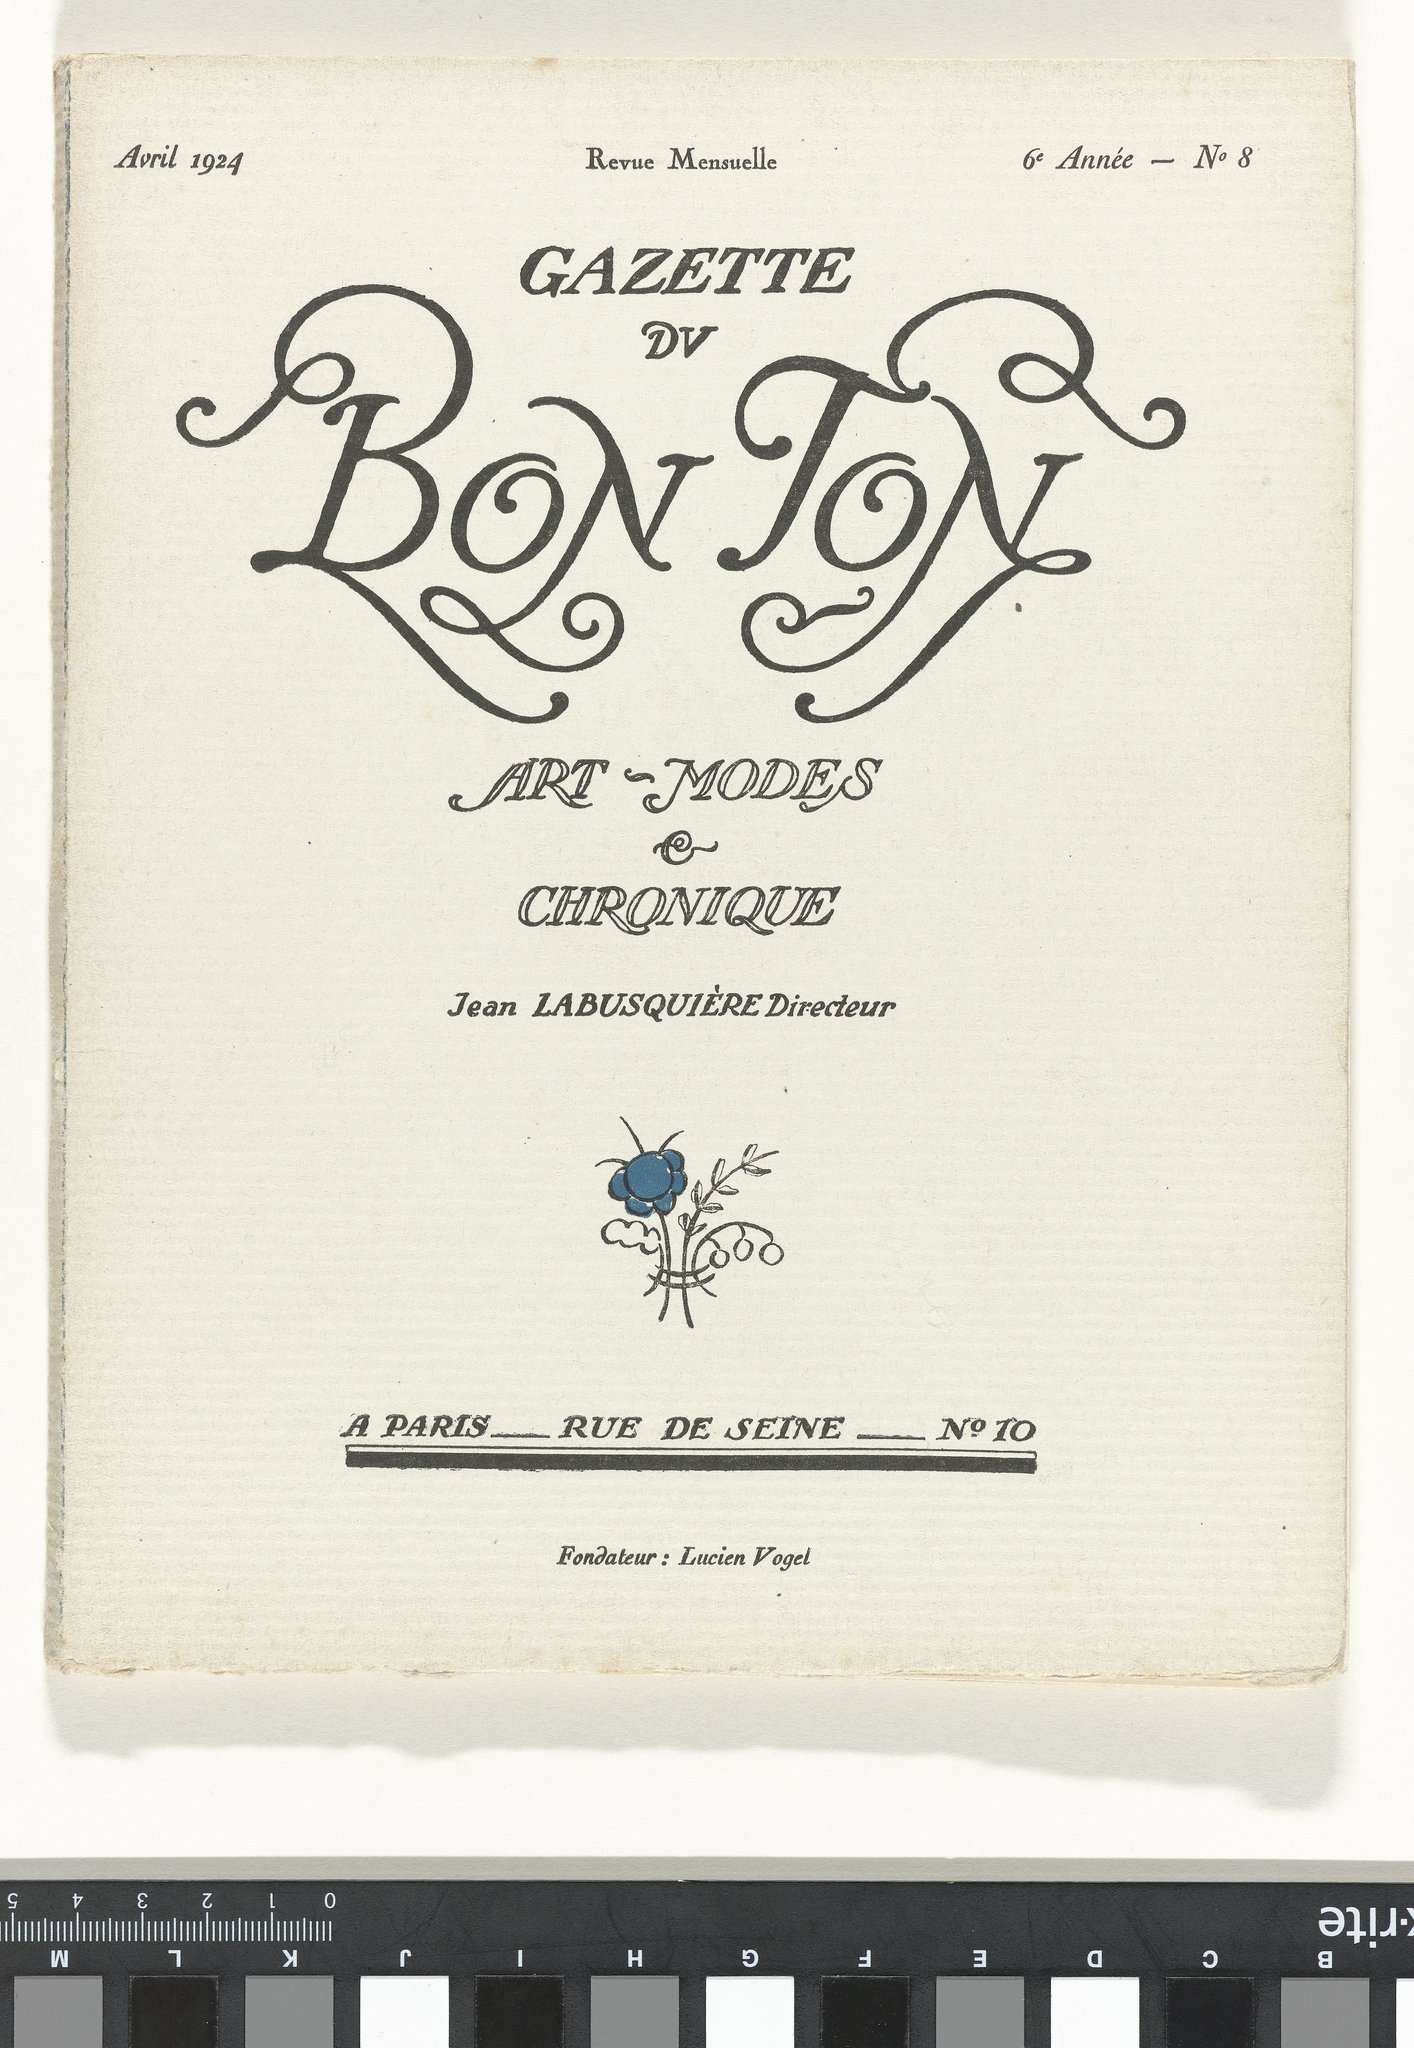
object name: fashion print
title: Gazette du Bon Ton. Art - Modes & Frivolités, No. 8 - 1924, 6e Année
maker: lucien vogel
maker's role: publisher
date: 1924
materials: paper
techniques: letterpress printing, pochoir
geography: paris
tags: fashion plates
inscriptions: date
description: Aflevering no. 8, april 1924, van Gazette du Bon Ton, bestaand uit een omslag, tien katernen met tekst en illustraties en zes losse prenten. Aan dit deel werkten de volgende modeontwerpers mee: Jenny, Lanvin, Paul Poiret, Madeleine Vionnet, Worth, Max A. Leroy, Perugia, Marthe Collot, Rodier, Bianchini en Ducharne.